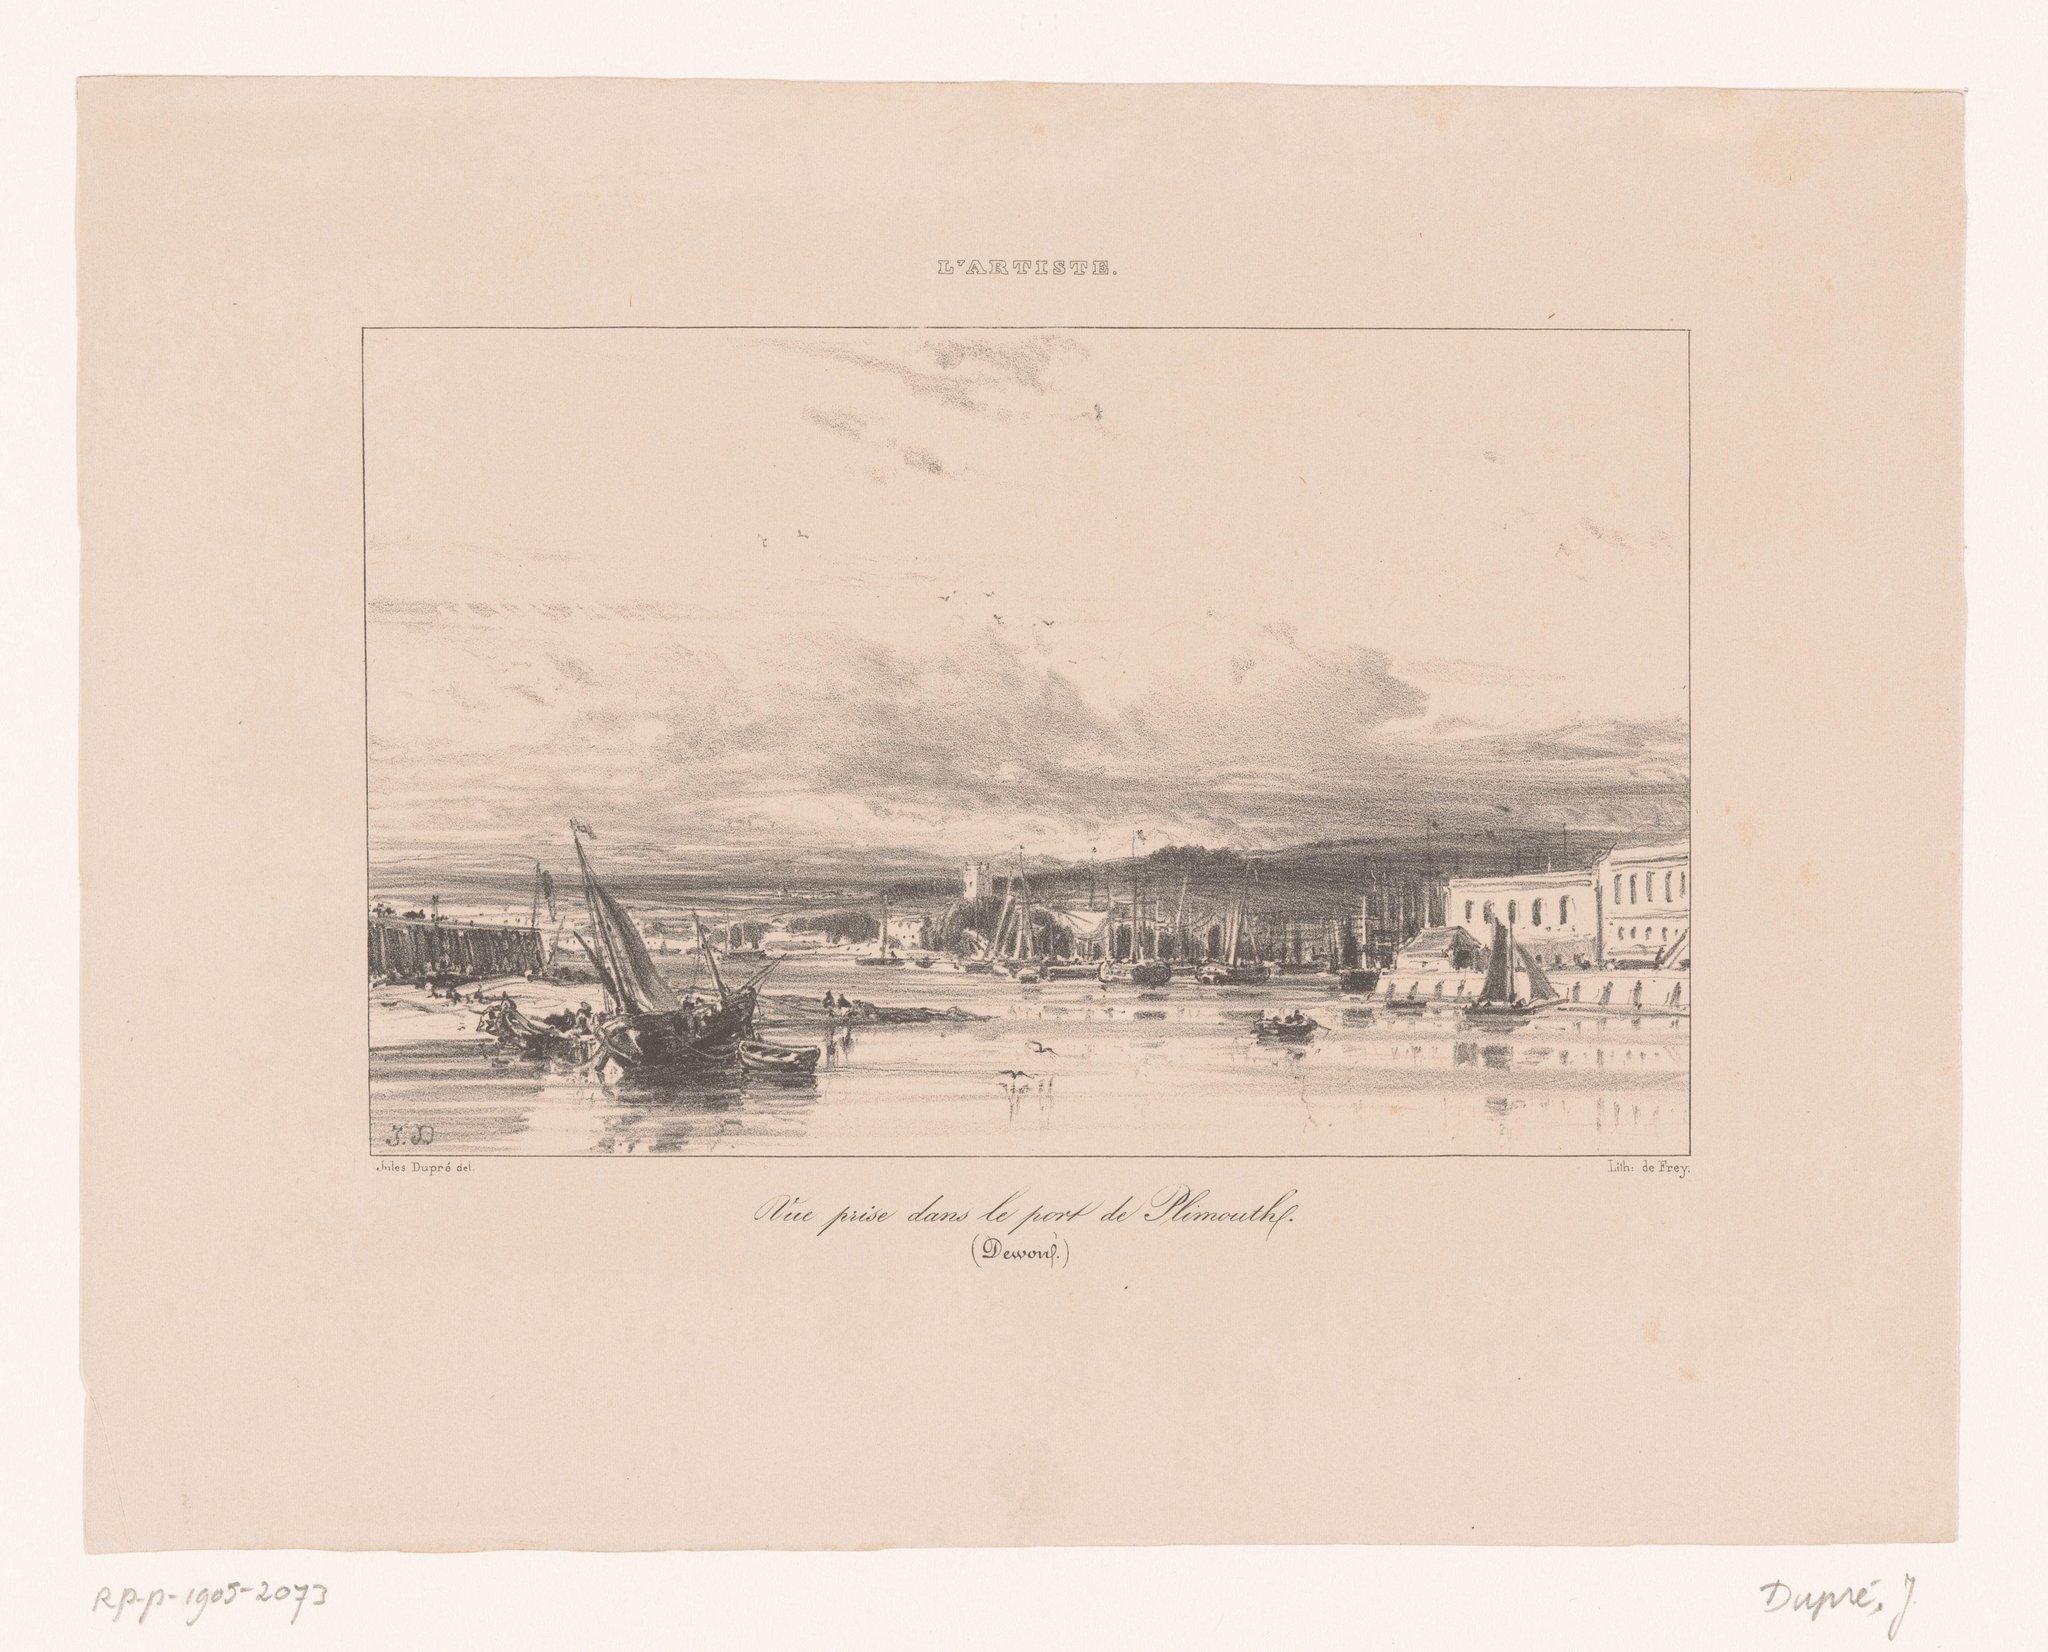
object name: print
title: Vue prise dans le port de Plimouth (Dewon)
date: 1836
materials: paper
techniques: lithograph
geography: paris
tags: harbour, plymouth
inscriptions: collector's mark: Lugt 2228a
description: Prent gebruikt voor: L'Artiste, journal de la littérature et des beaux-arts, 1836.